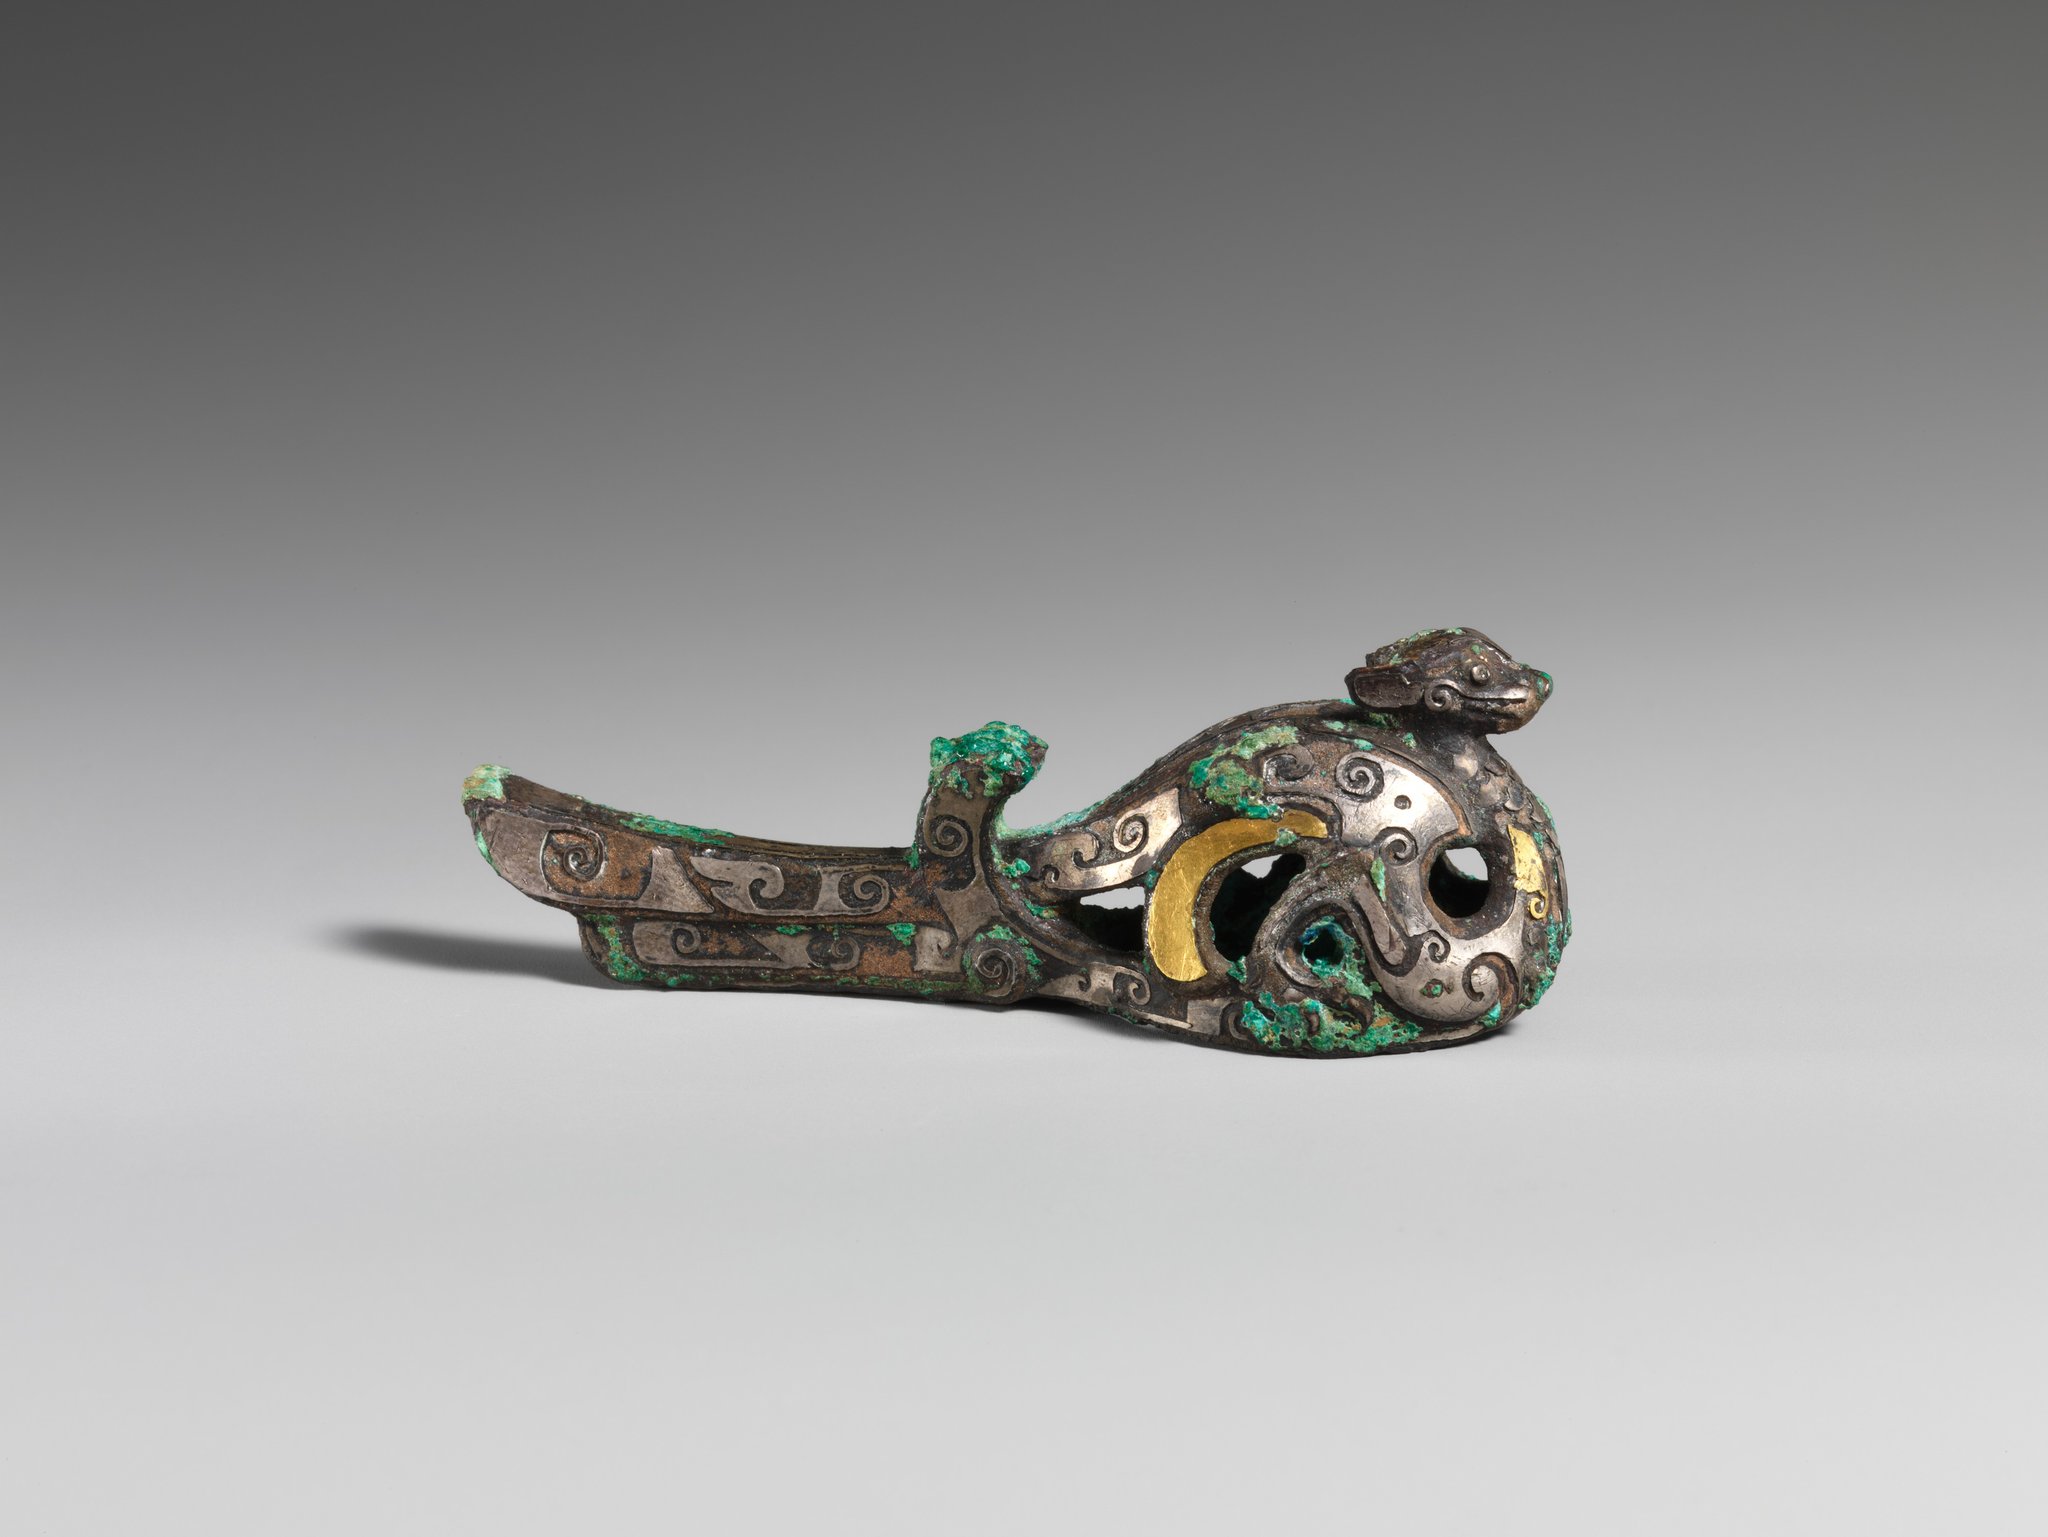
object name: finial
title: Finial in the shape of a bird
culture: chinese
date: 500-201 BCE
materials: bronze, gold, silver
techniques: inlay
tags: birds